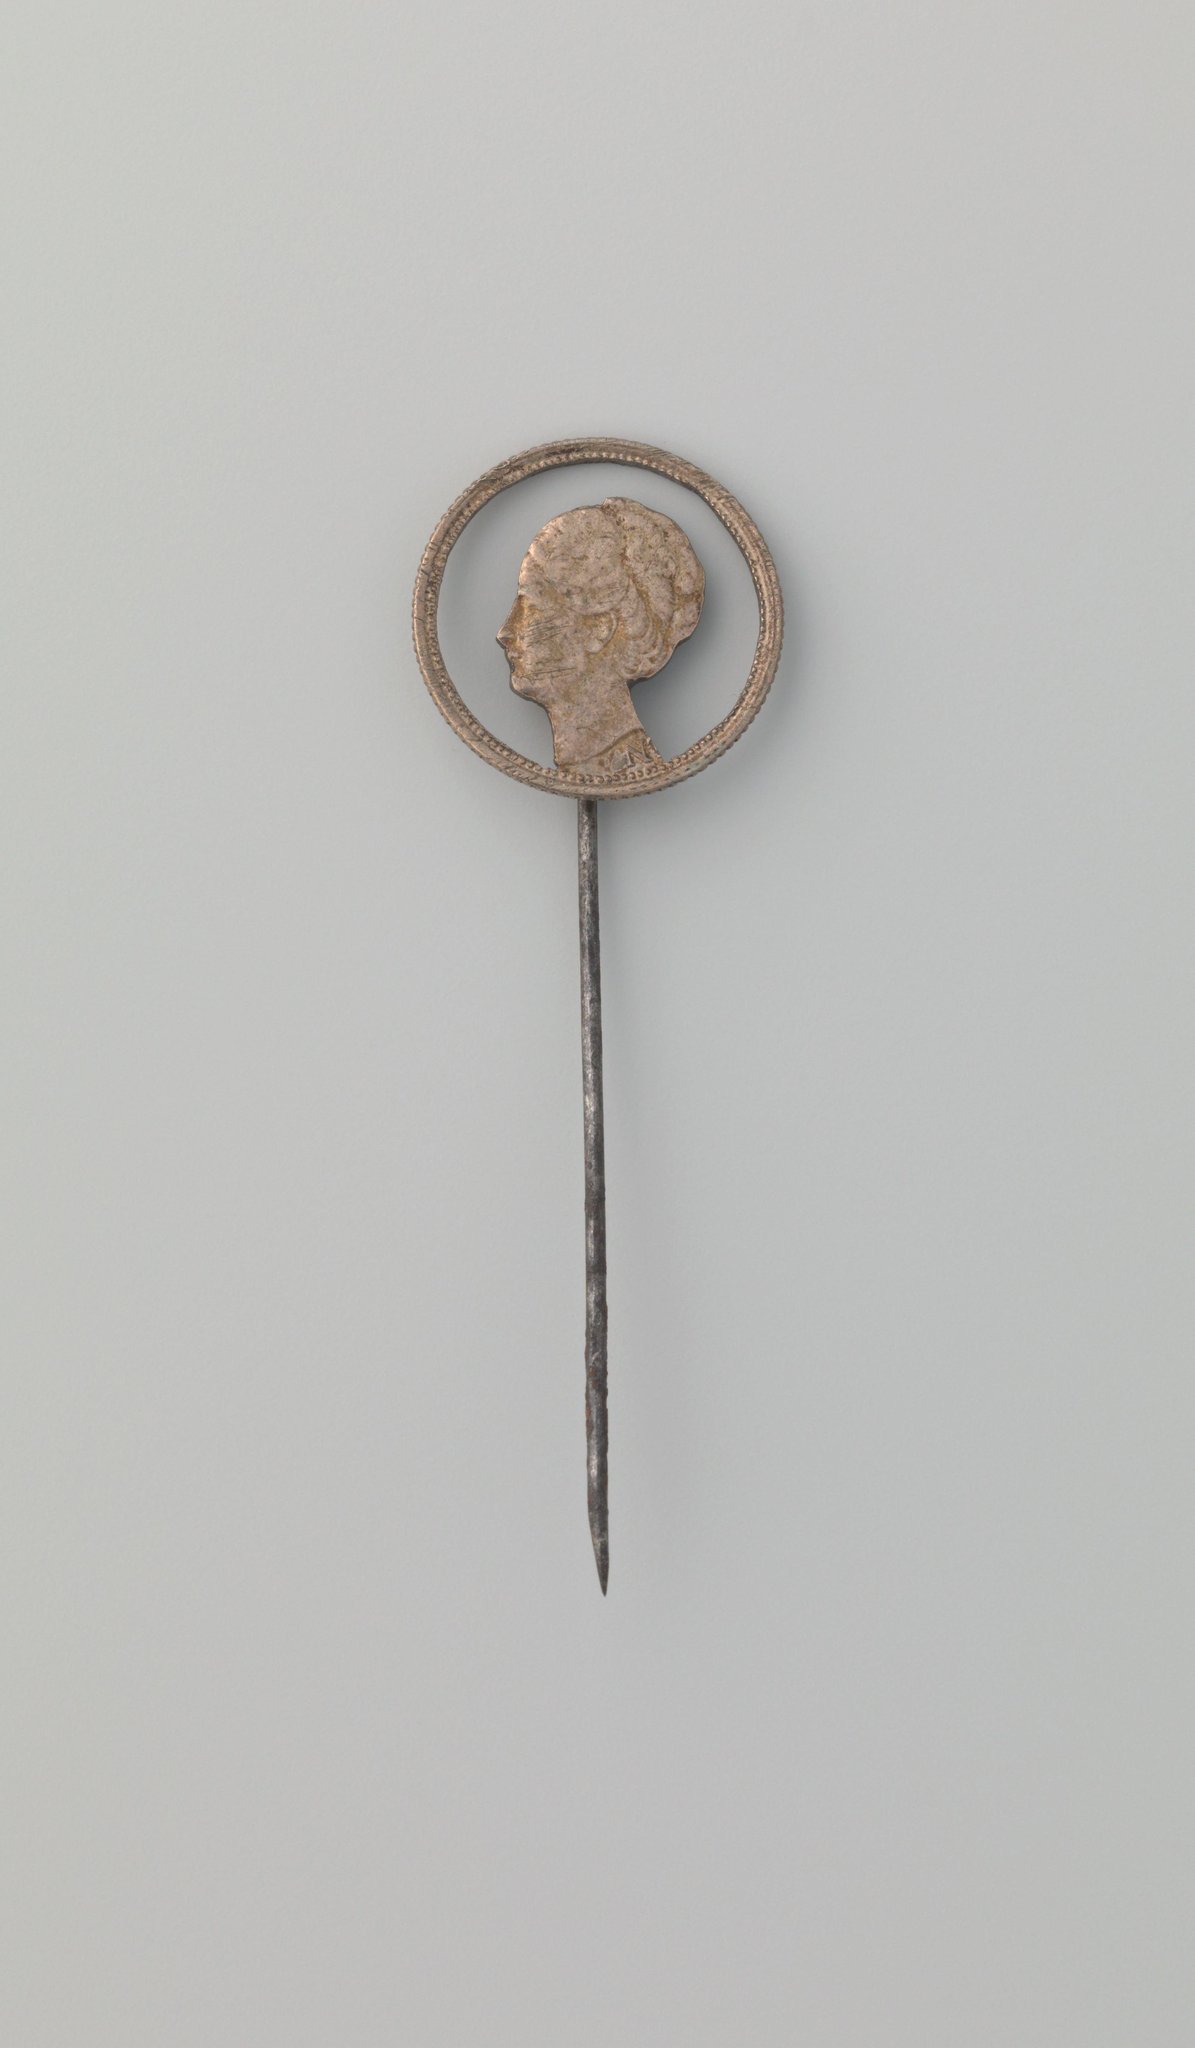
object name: lapel pin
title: Reversspeld van een uitgezaagd dubbeltje met de beeldenaar van Wilhelmina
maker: Anonymous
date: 1940-1950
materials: silver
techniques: sawing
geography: netherlands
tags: the hague, print maker, wilhelmina of the netherlands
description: Reversspeld van een uitgezaagd dubbeltje met de beeldenaar van Wilhelmina.